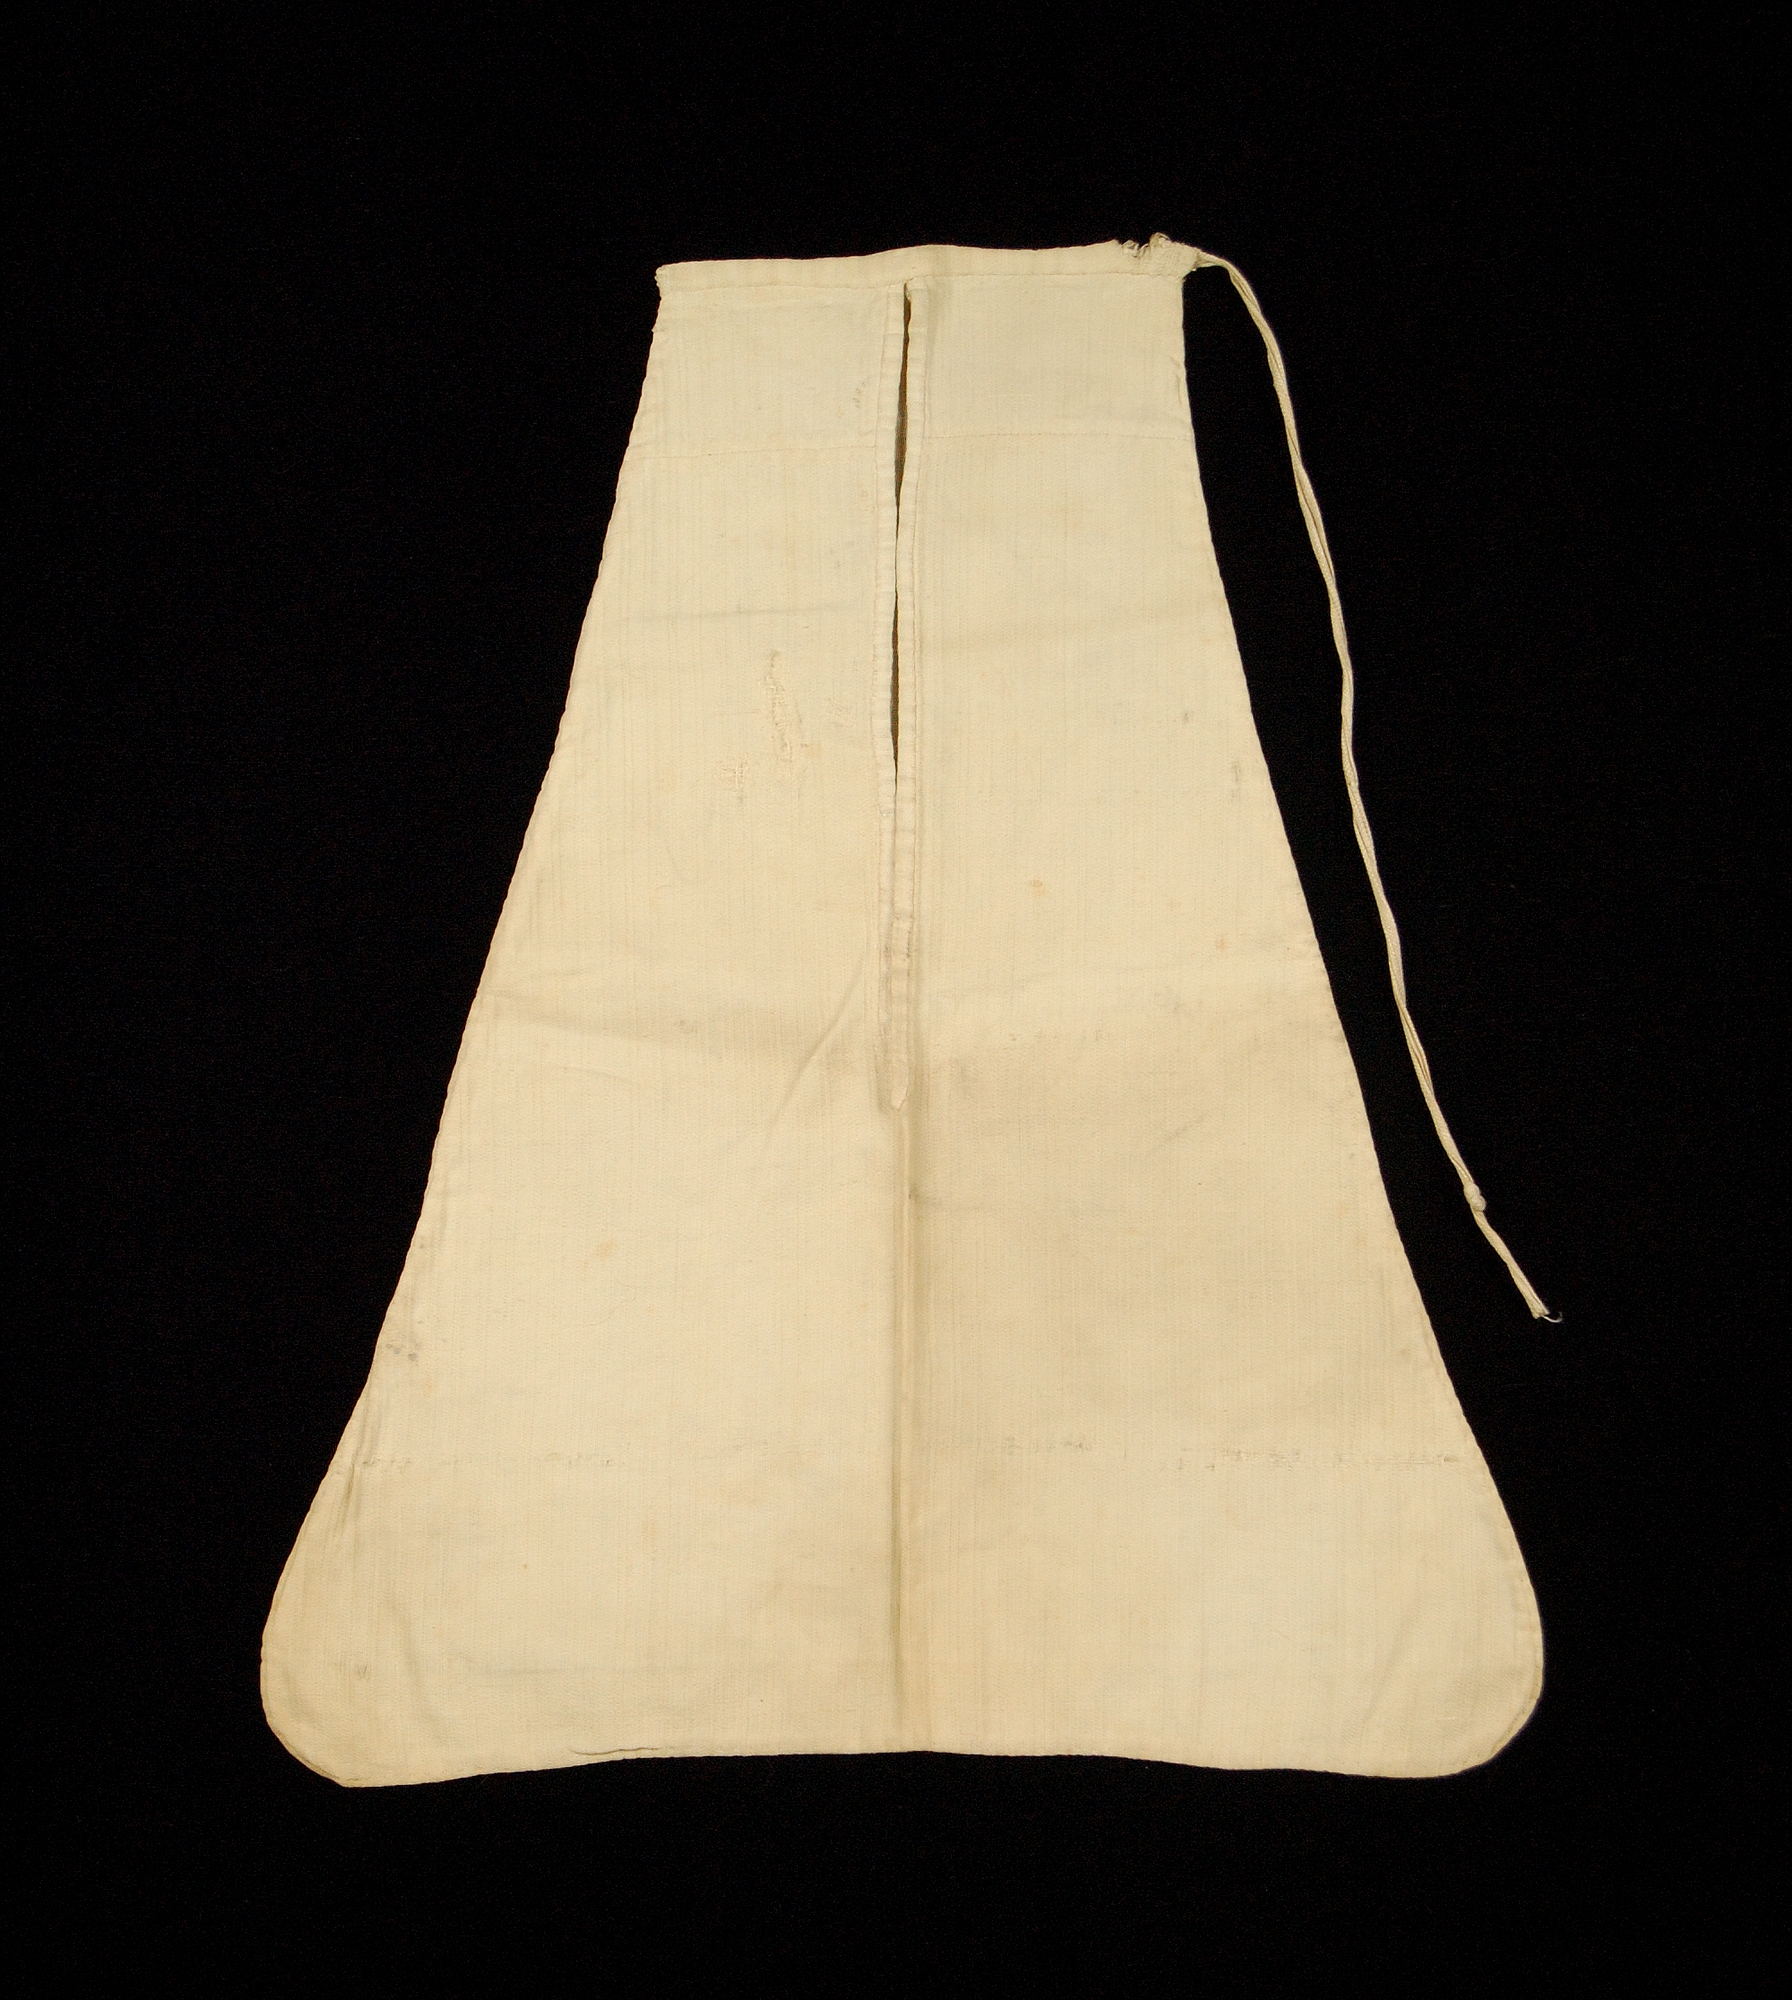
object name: pocket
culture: american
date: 1809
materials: cotton, linen